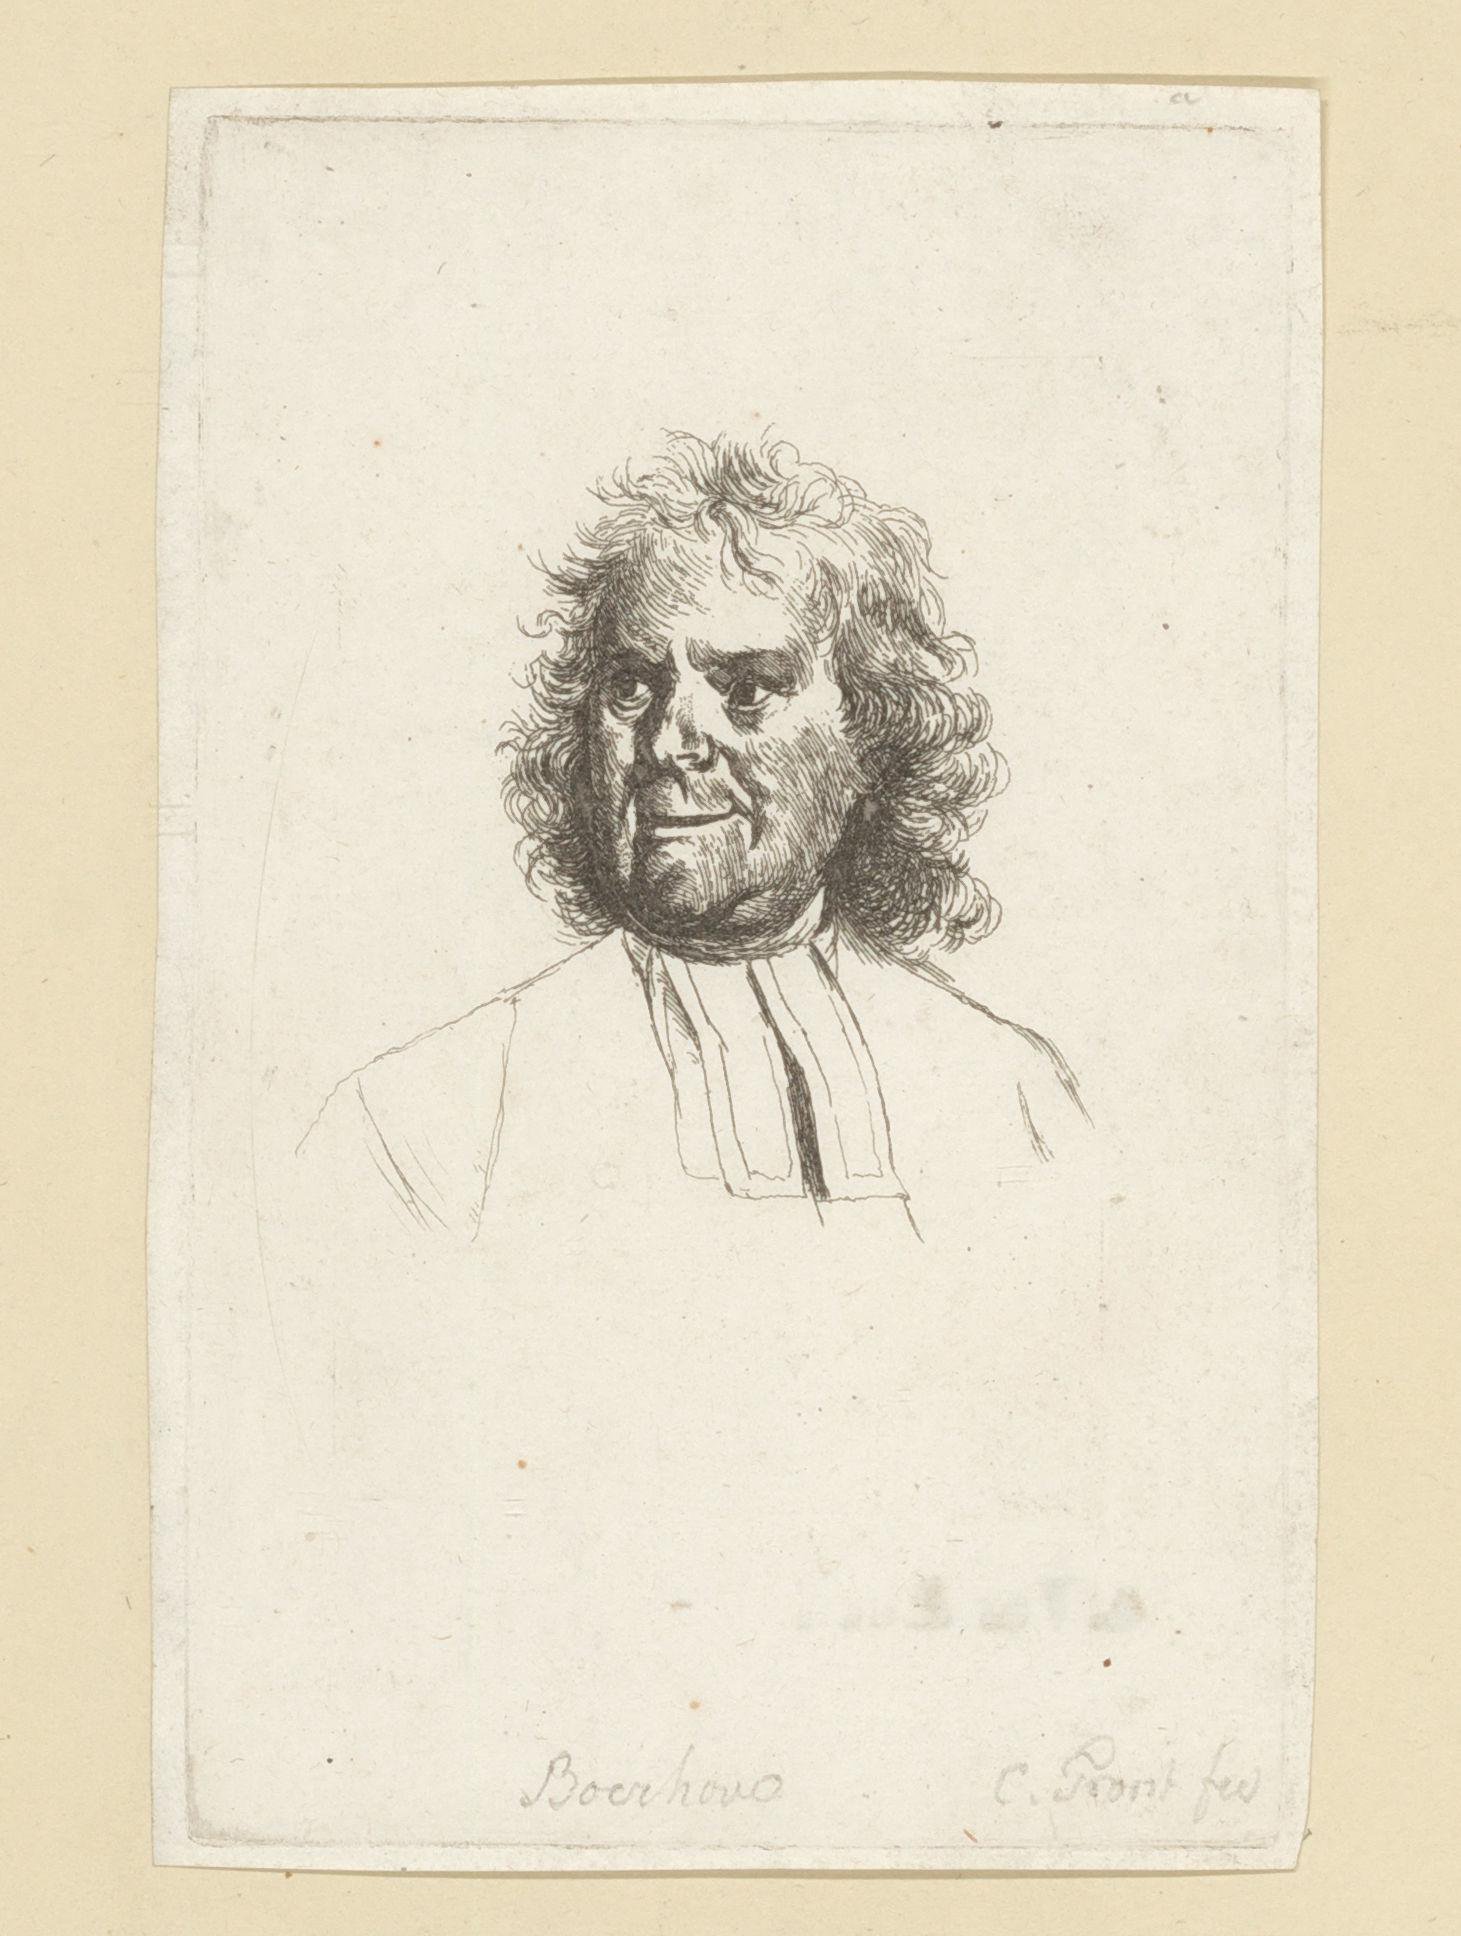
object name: print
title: Portret van Hermanus Boerhaave (versie A)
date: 1762-1782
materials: paper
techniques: etching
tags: leiden, hermanus boerhaave, historical persons, physician, doctor (+ scholar, scientist (at work))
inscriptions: collector's mark: Lugt 2488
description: Portret van Hermanus Boerhaave, buste, driekwart naar links. Versie A van het portret, door Ver Huell aan Troost zelf toegeschreven.